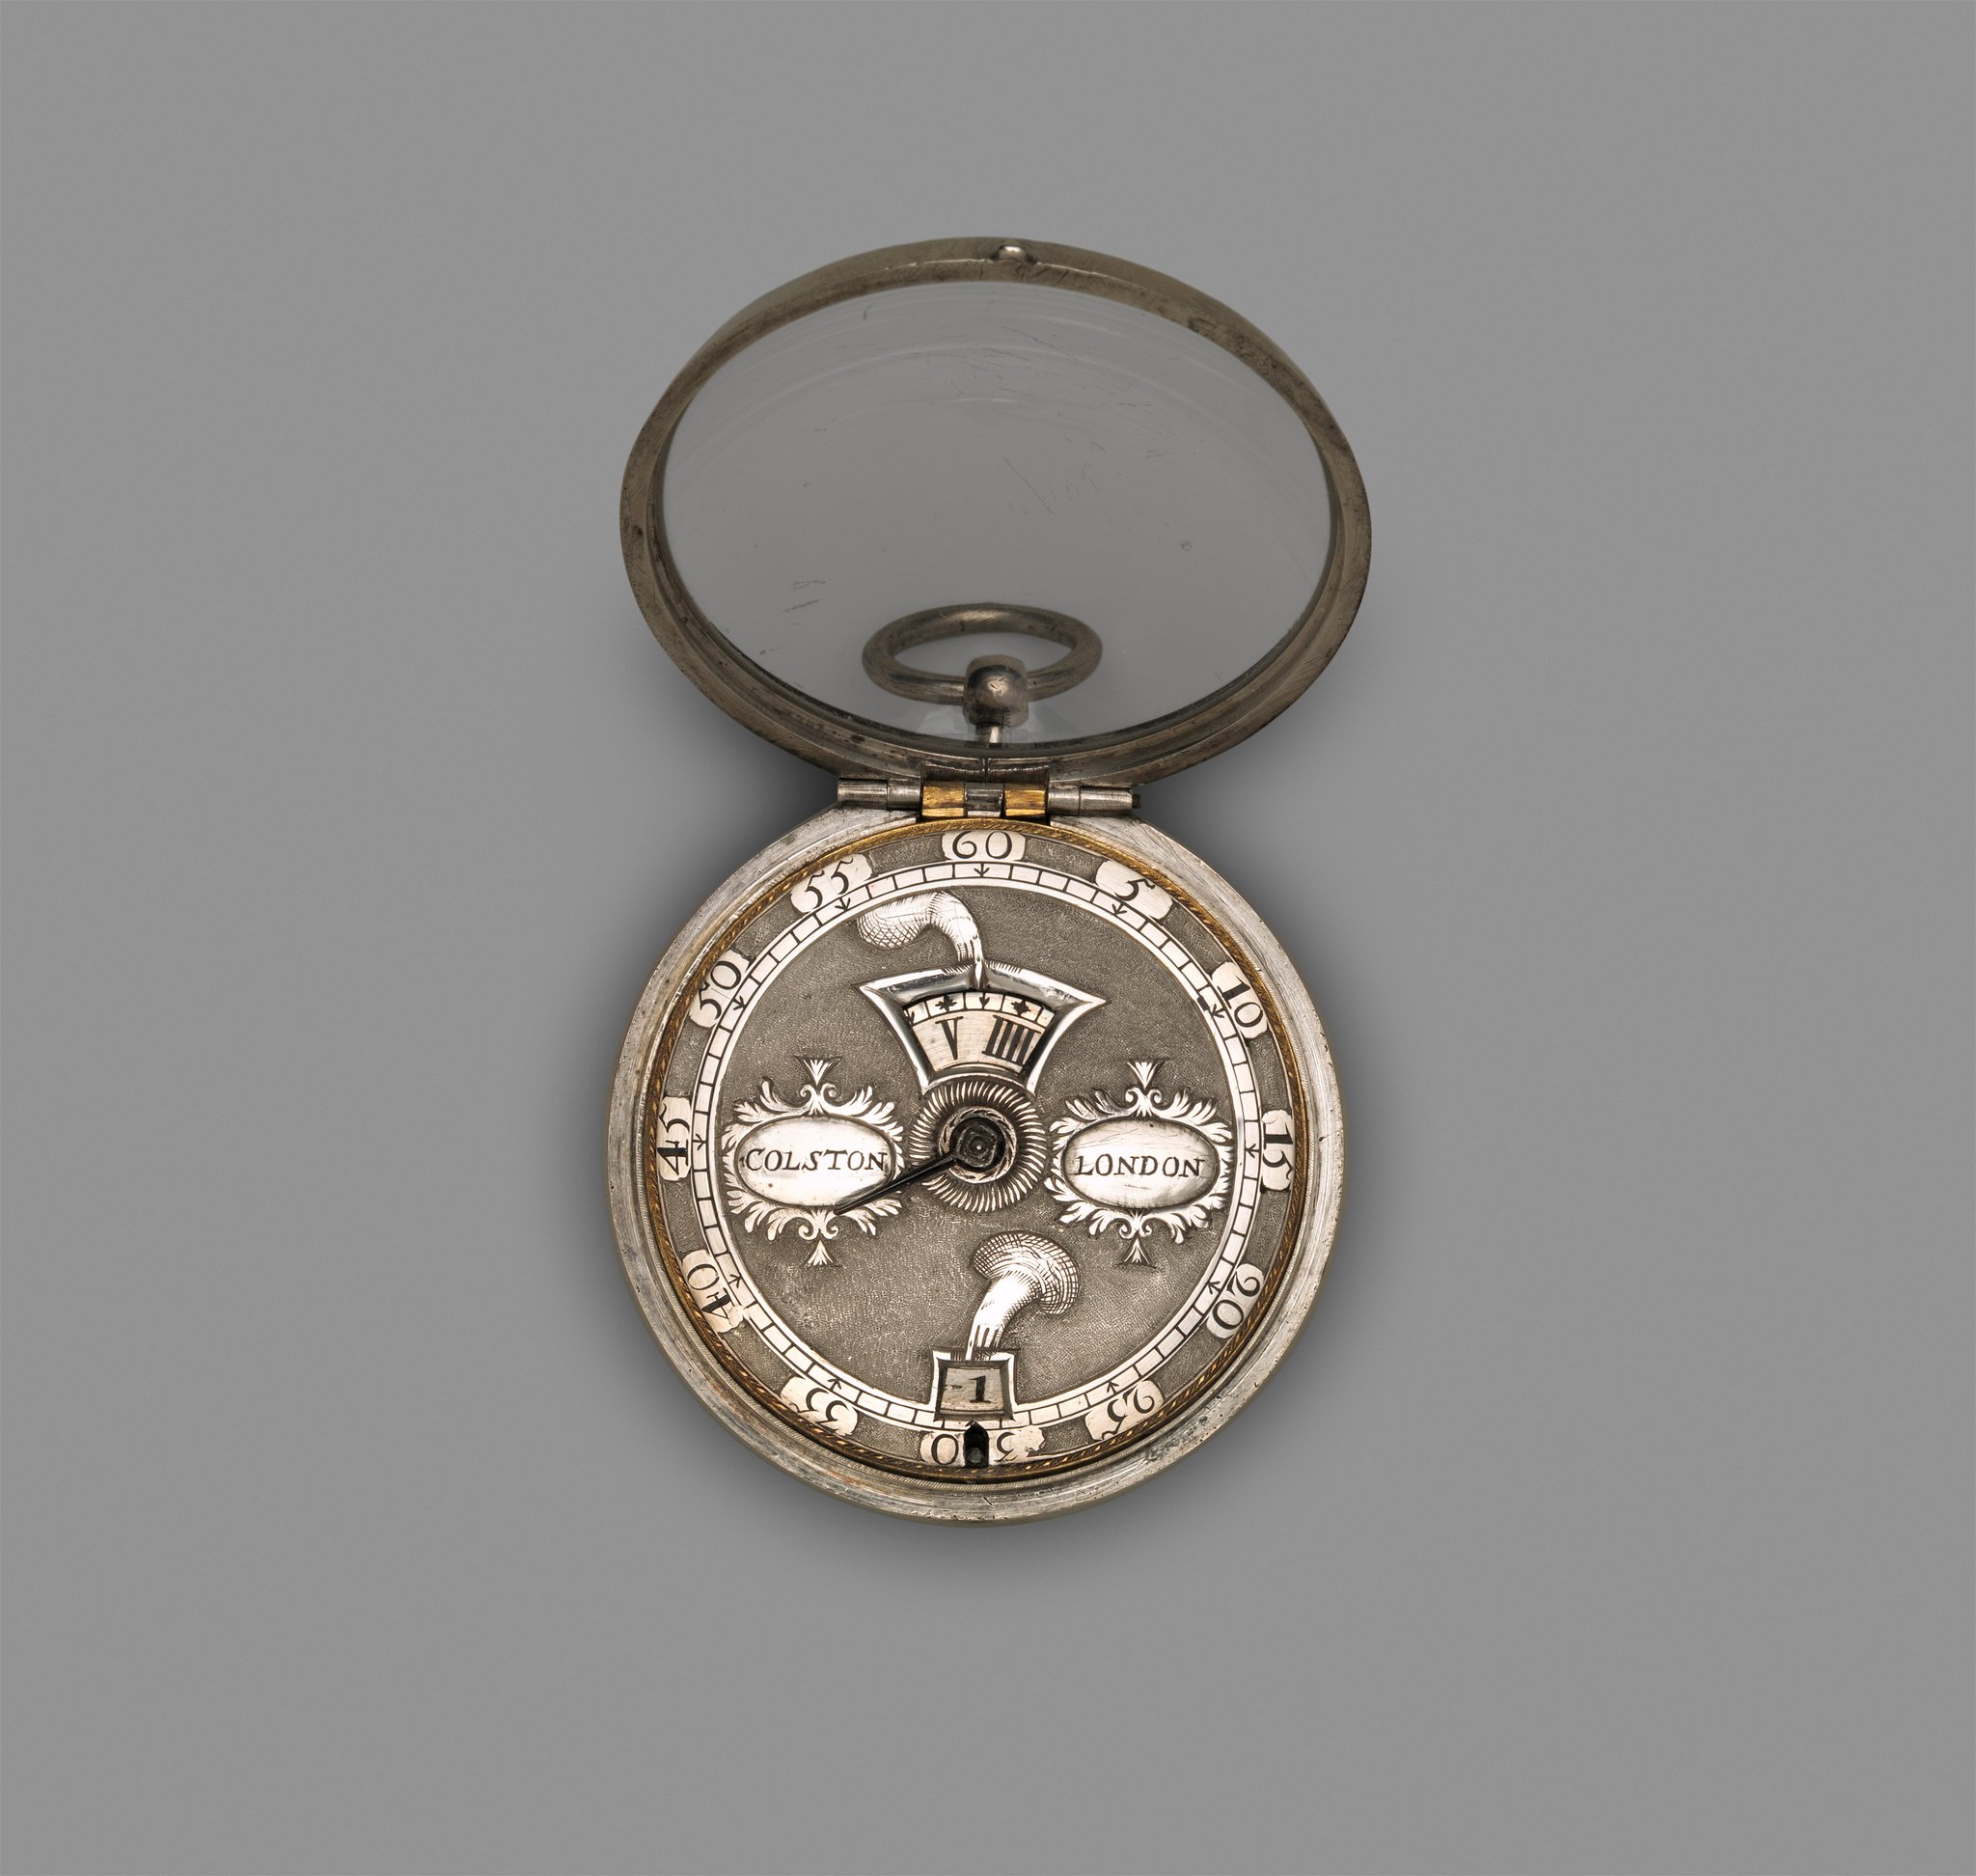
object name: pair case watch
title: Pair-case watch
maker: richard colston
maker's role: maker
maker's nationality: british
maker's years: 1652-1739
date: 1690-1700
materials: enamel, silver, shell, metal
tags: coat of arms